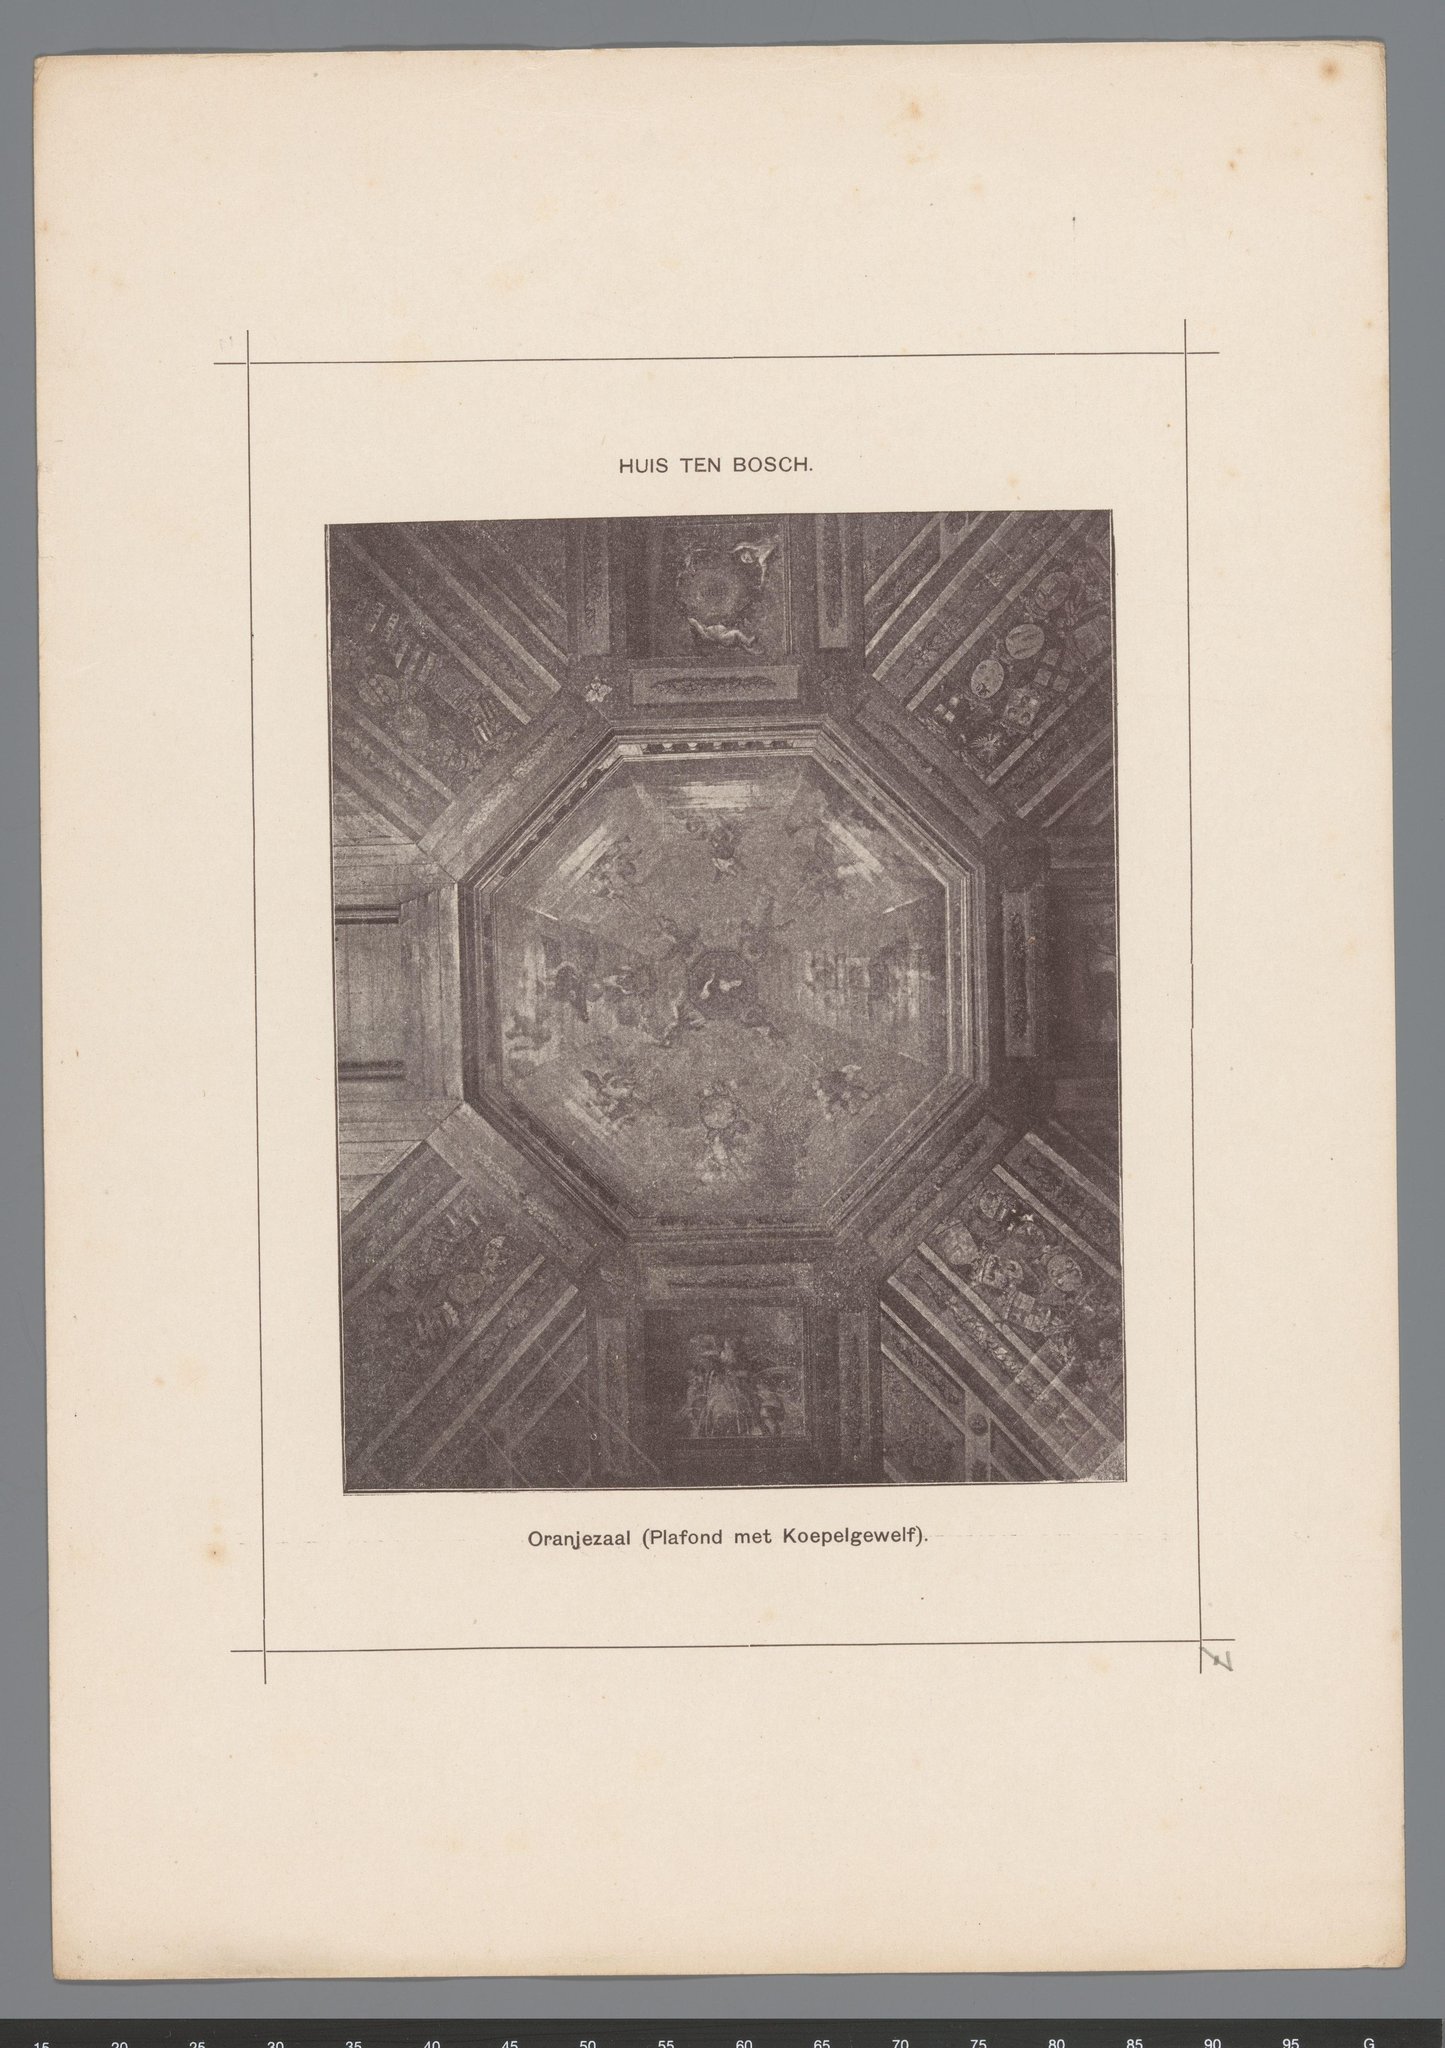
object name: photomechanical print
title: Oranjezaal (Plafond met Koepelgewelf)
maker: Anonymous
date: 1880-1925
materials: paper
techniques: autotype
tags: palace - aa - civic architecture: inside, palace, (decorated) ceiling, the hague